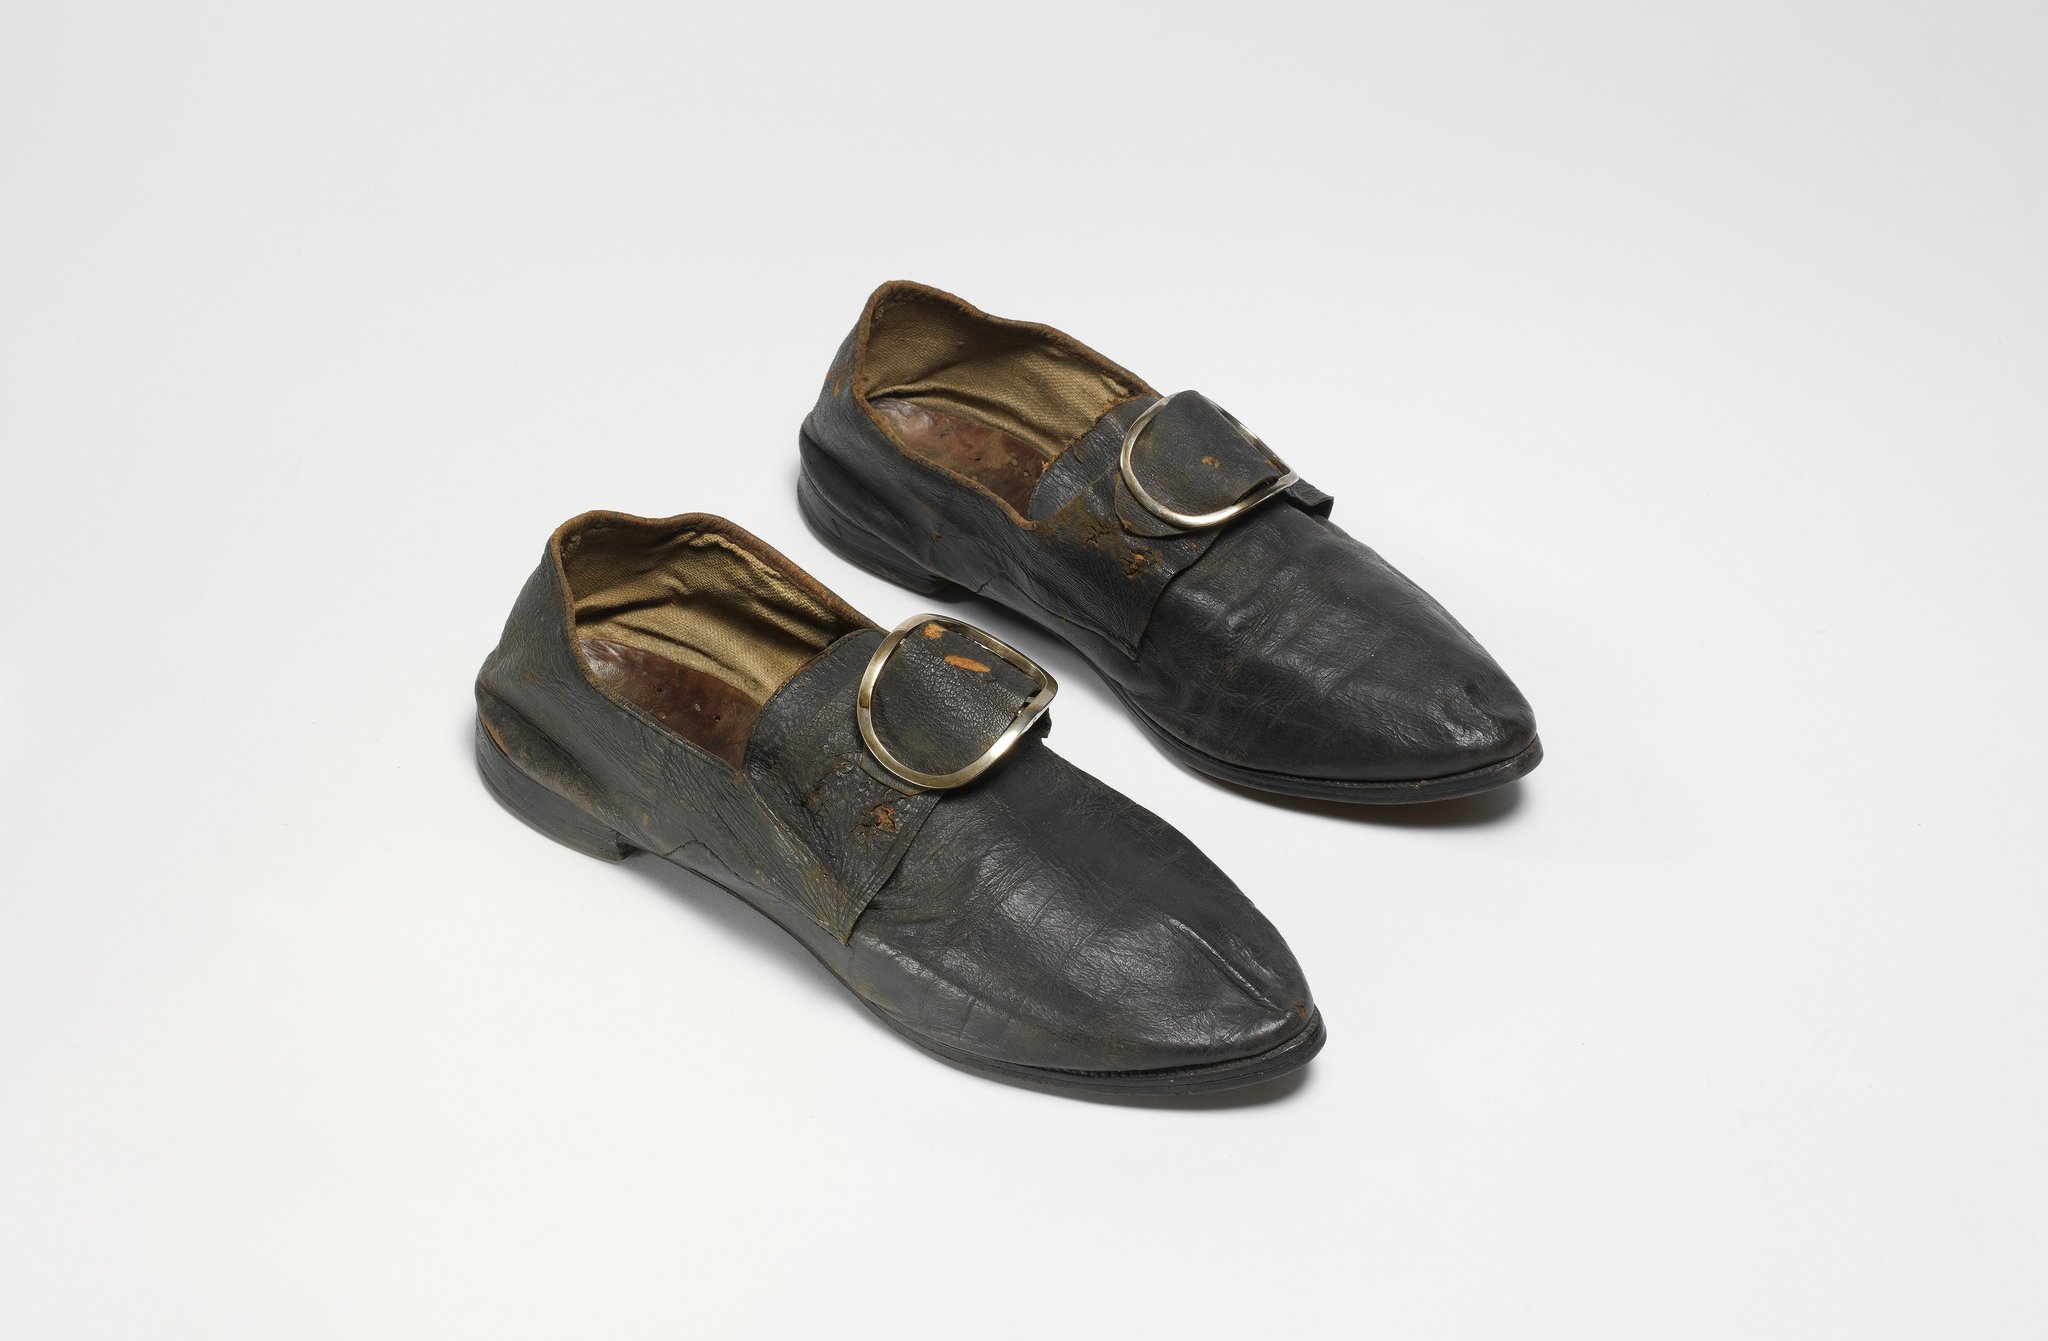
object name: shoe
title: Shoes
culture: british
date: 1767-1800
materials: leather